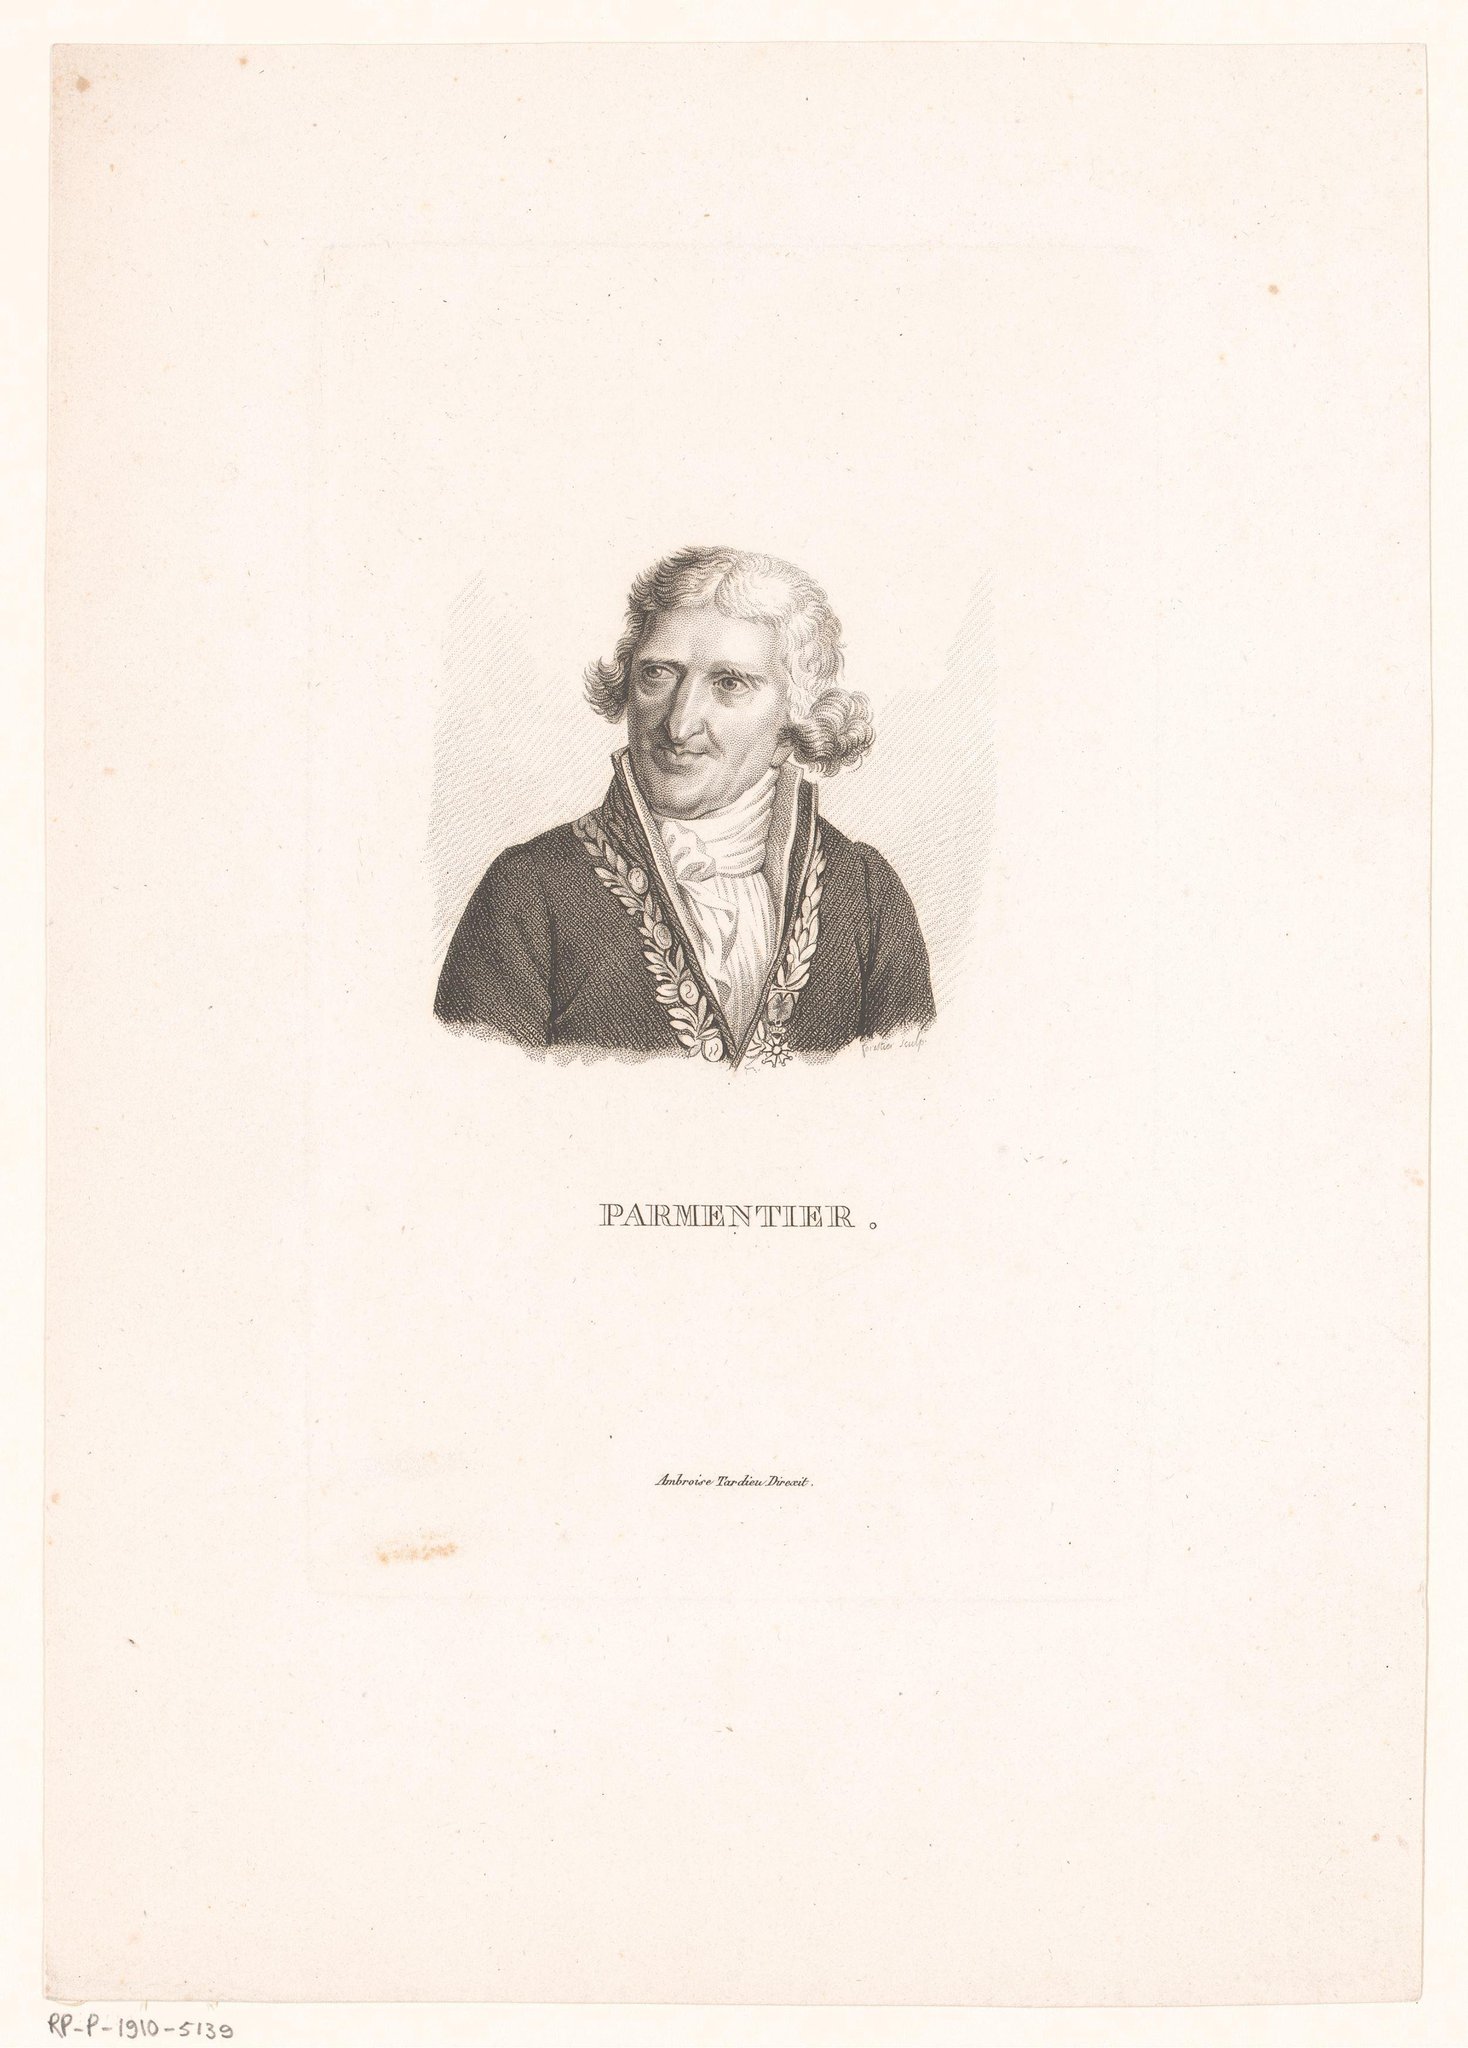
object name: print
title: Portret van Antoine-Augustin Parmentier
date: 1818-1832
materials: paper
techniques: engraving, roulette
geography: paris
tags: pharmacist, druggist, apothecary; pharmacy, drugstore, dispensing chemist, historical persons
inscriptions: collector's mark: Lugt 2228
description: Mogelijk prent uit: Journal complémentaire du Dictionnaire des sciences médicales. Parijs: Panckoucke, Charles Louis Fleury, 1818-1832.